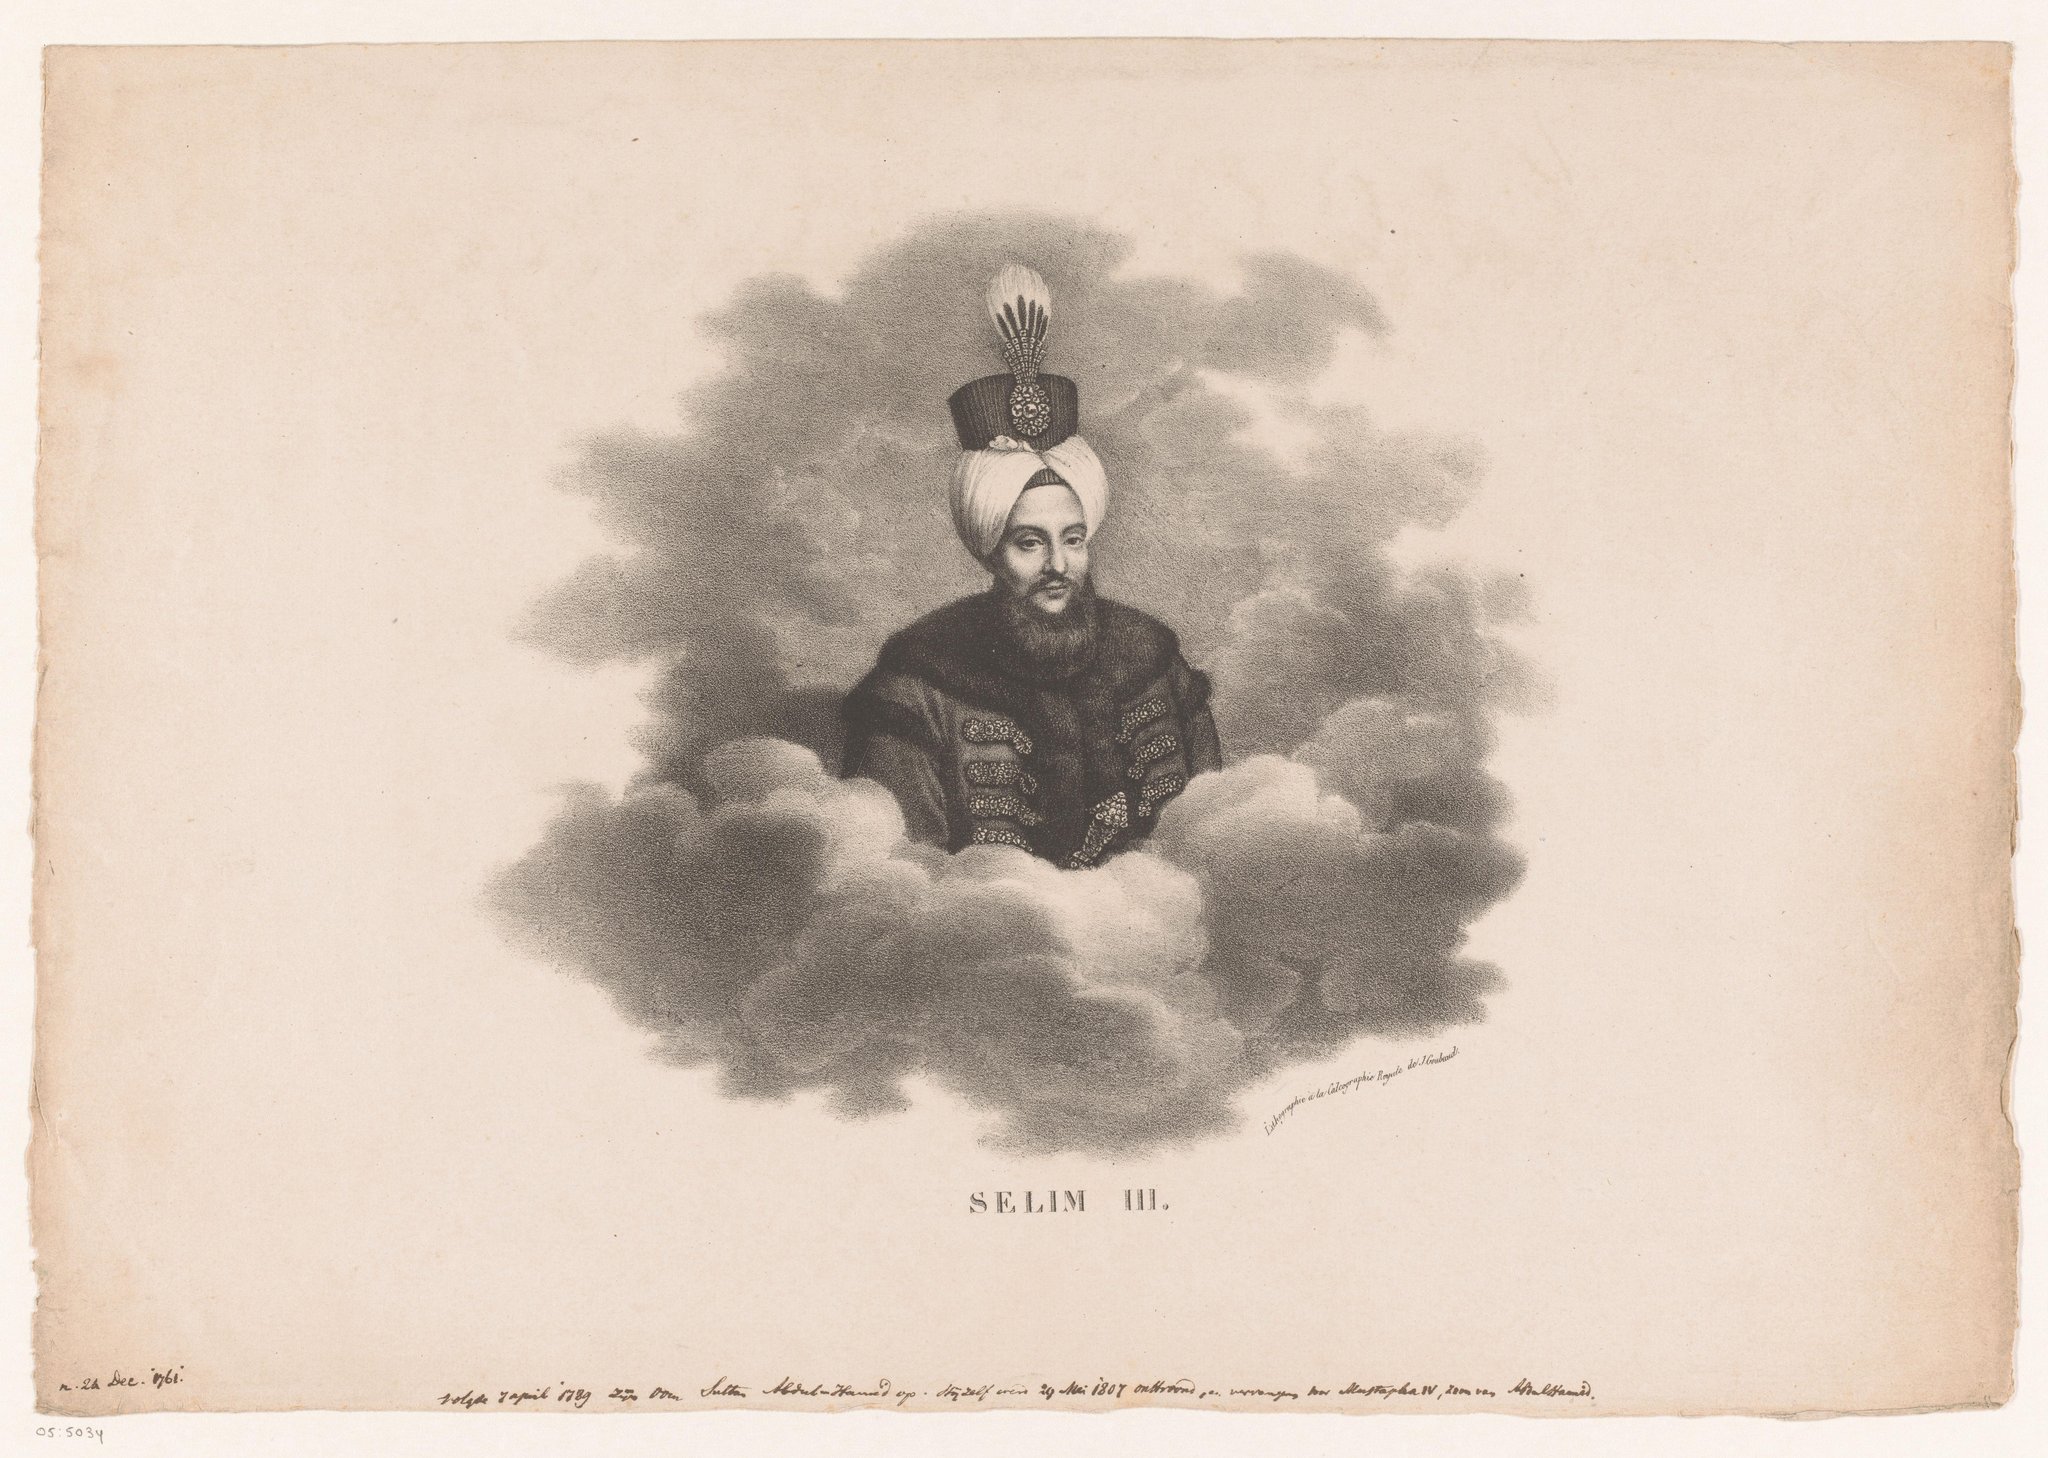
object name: print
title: Portret van Selim III omringd door wolken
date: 1780-1847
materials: paper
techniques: lithograph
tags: adult man, historical persons, head-gear: turban, beard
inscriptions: inscription: ‘24 dec. 1761; Volgde 7 april 1789 zijn oom sultan [...] op. Hijzelf den 29 mei 1807 onttroond [...]’, collector's mark: Lugt 2228